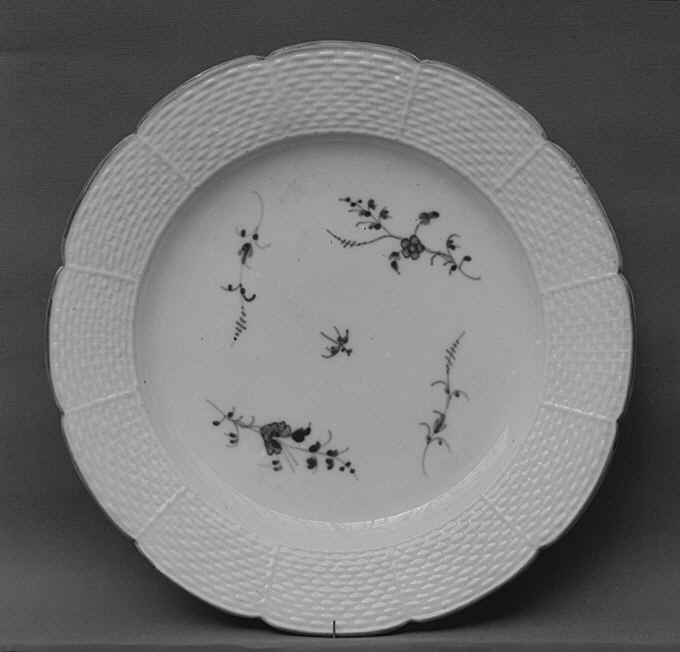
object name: plate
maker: chantilly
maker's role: factory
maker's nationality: french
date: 1770-1775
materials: soft paste porcelain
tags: flowers